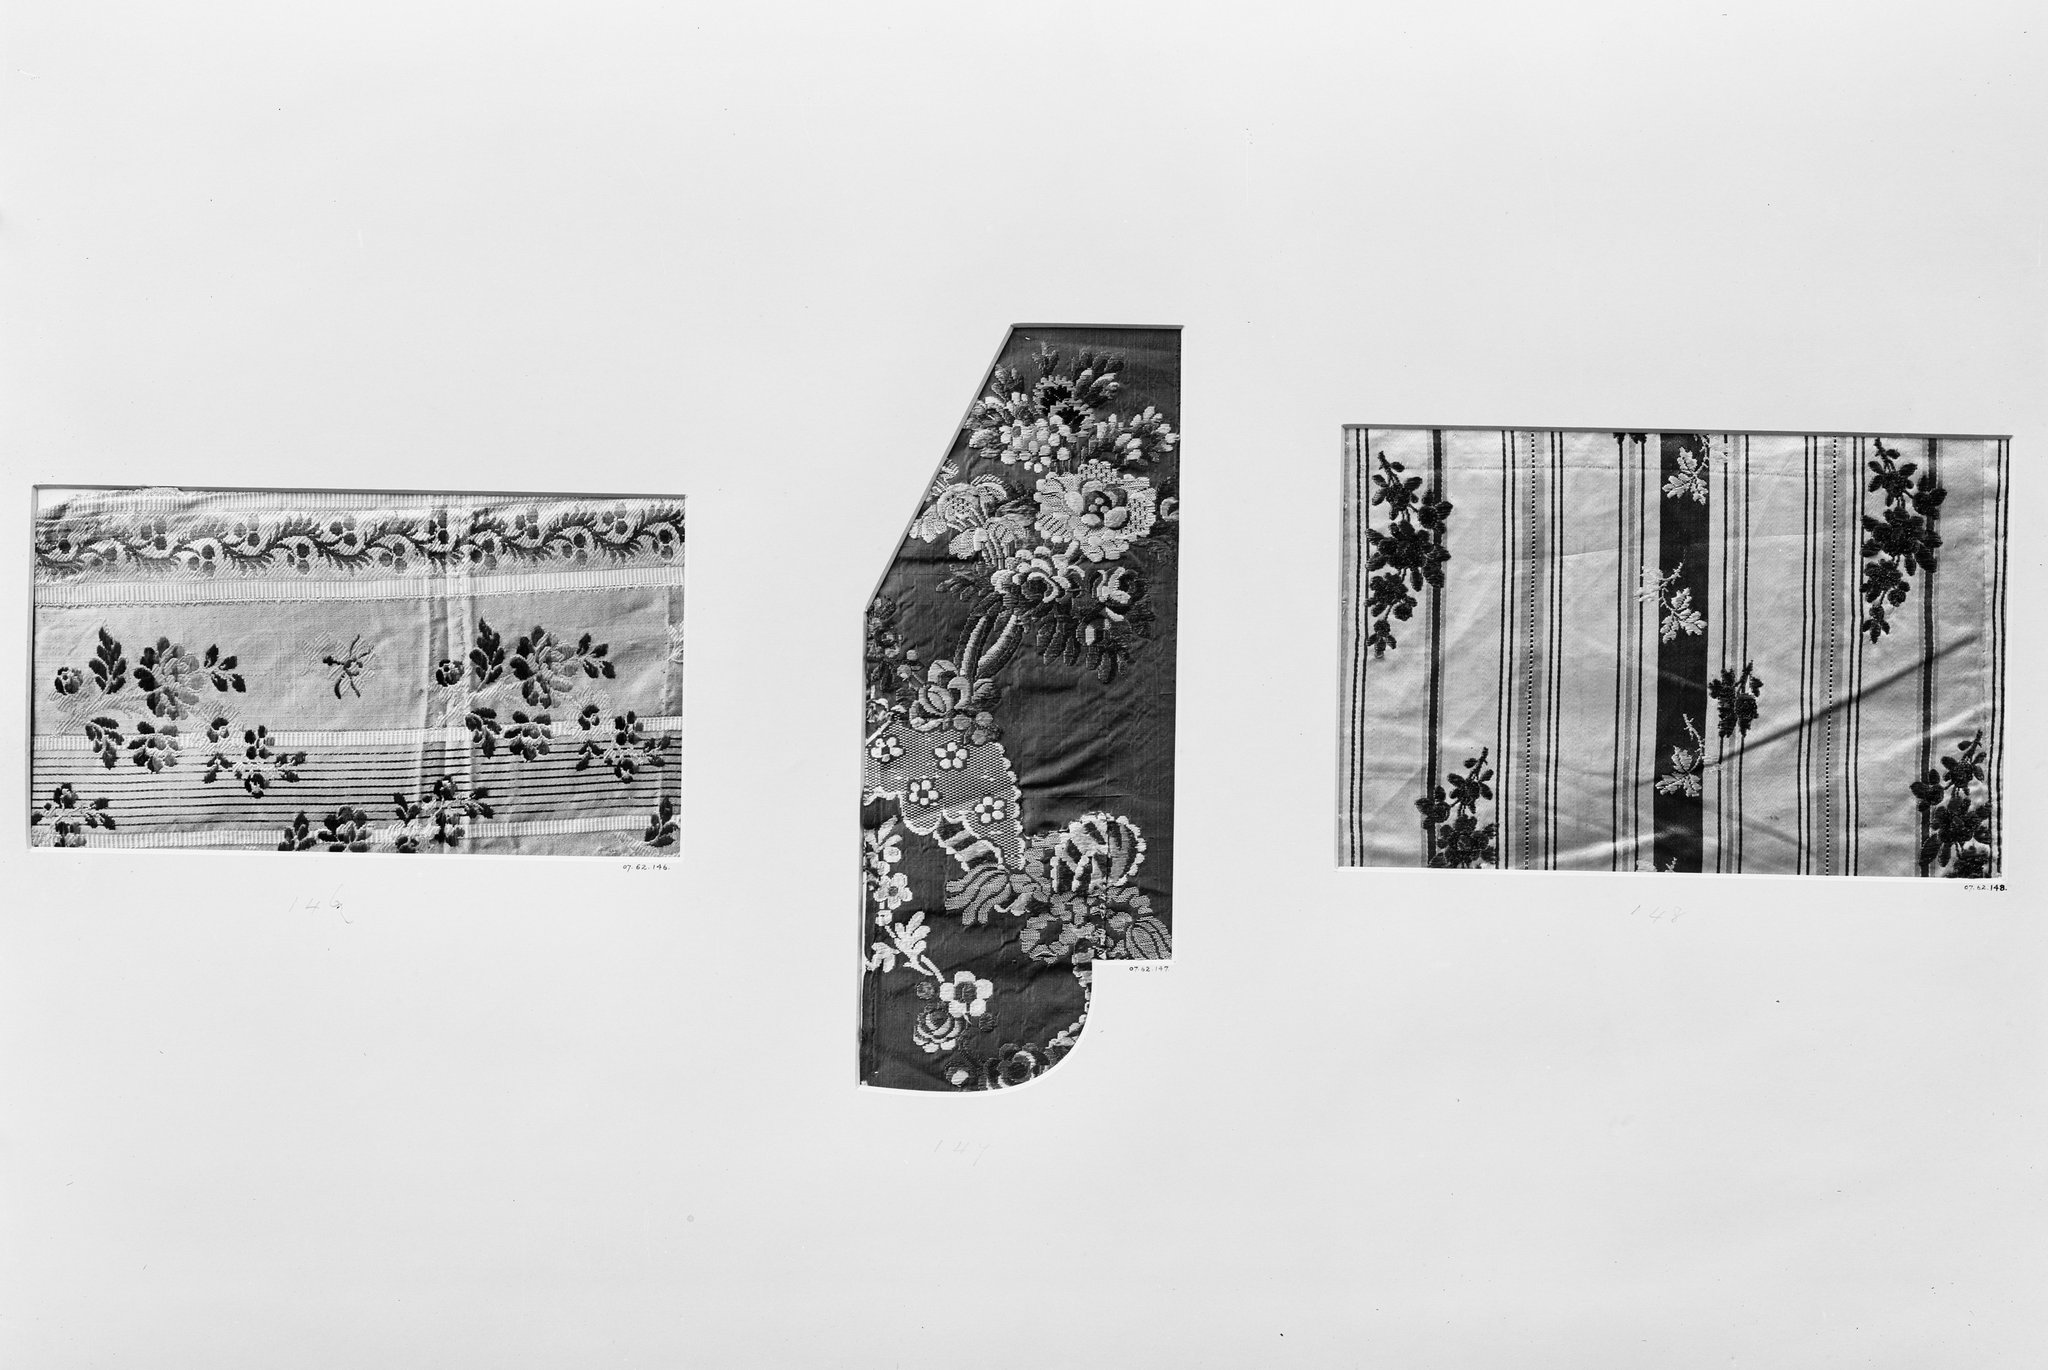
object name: piece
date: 1701-1800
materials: silk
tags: flowers,leaves